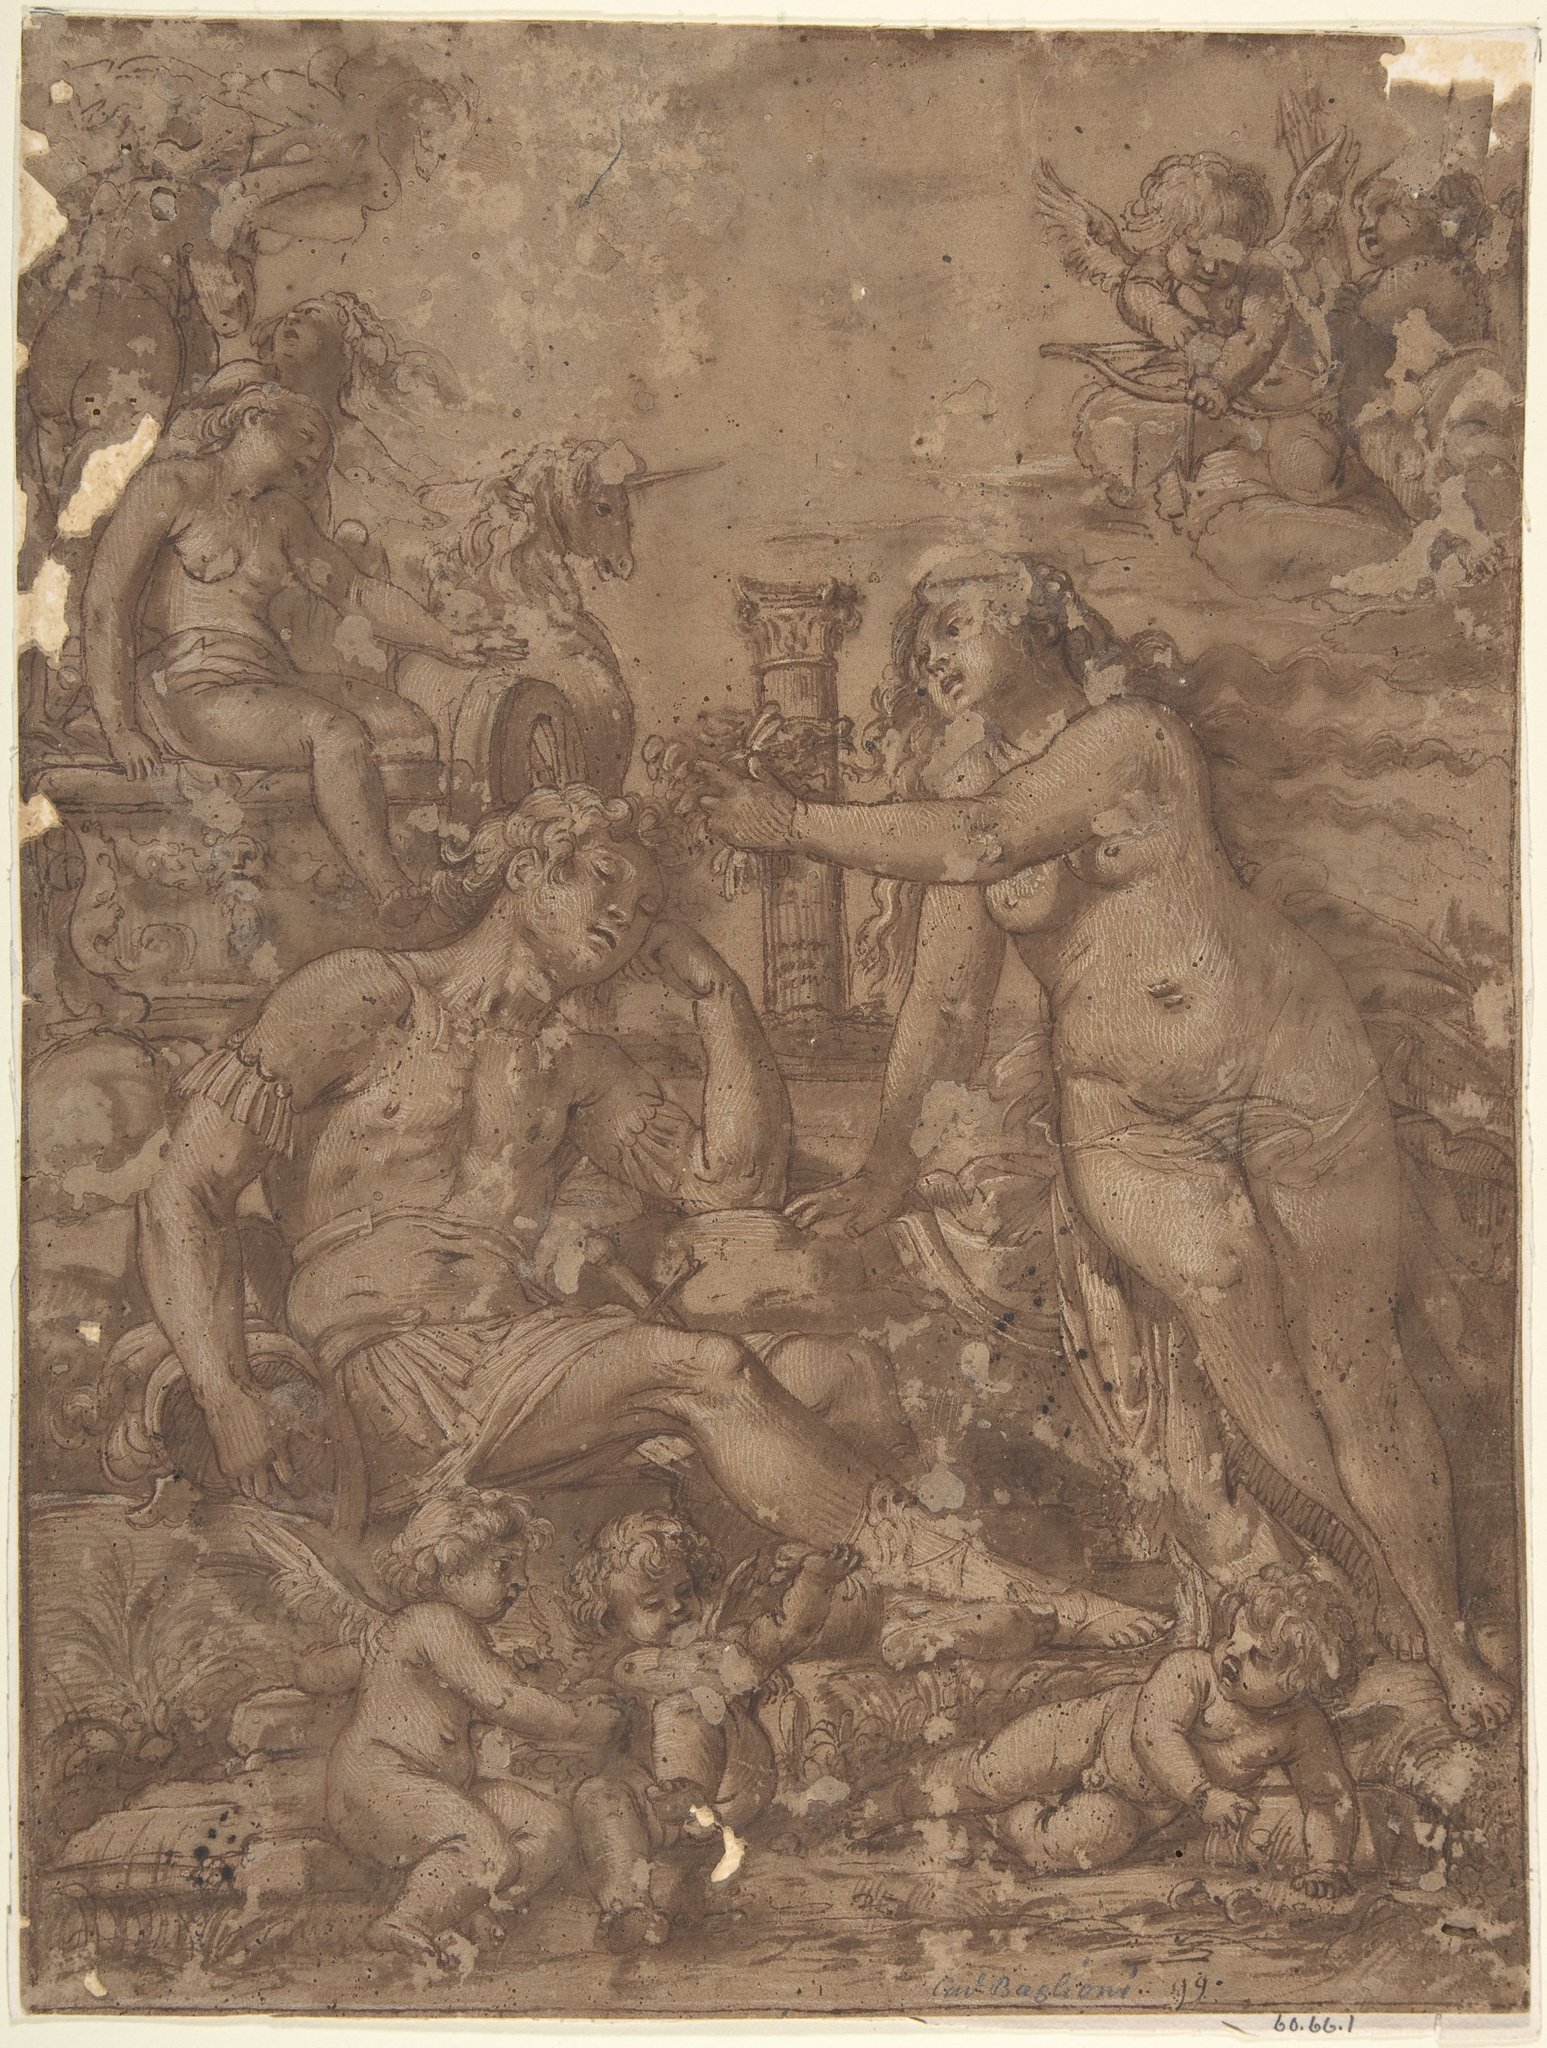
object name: drawing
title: Rinaldo and Armida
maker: giovanni baglione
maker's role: artist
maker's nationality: italian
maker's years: 1566-1643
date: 1566-1643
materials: ink, paper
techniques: brush, highlighting, pen, wash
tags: men,female nudes